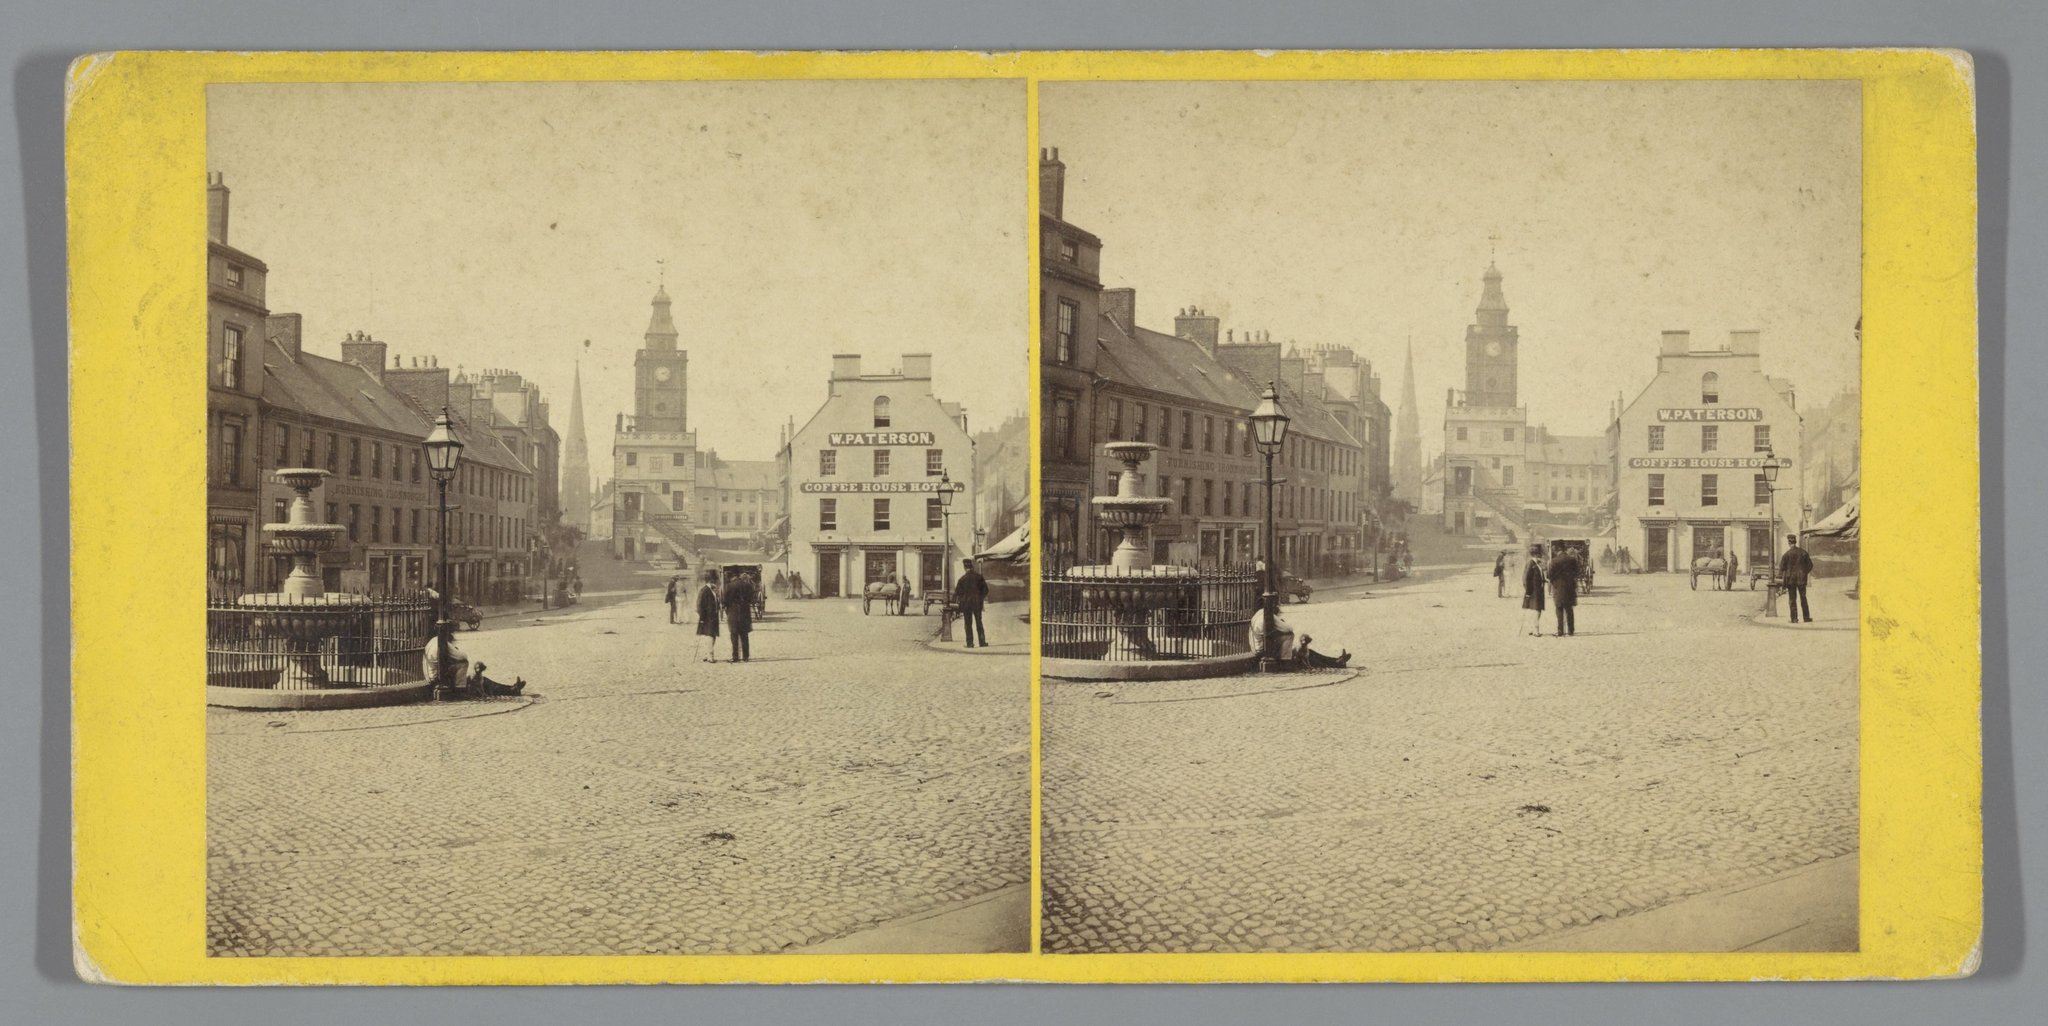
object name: stereograph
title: Gezicht op Highstreet in Dumfries, Schotland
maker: george washington wilson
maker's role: publisher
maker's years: 1823-1893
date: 1861-1870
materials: cardboard, paper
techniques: albumen print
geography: dumfries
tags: street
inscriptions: inscription: ‘Registered’, number: ‘No. 1006.’